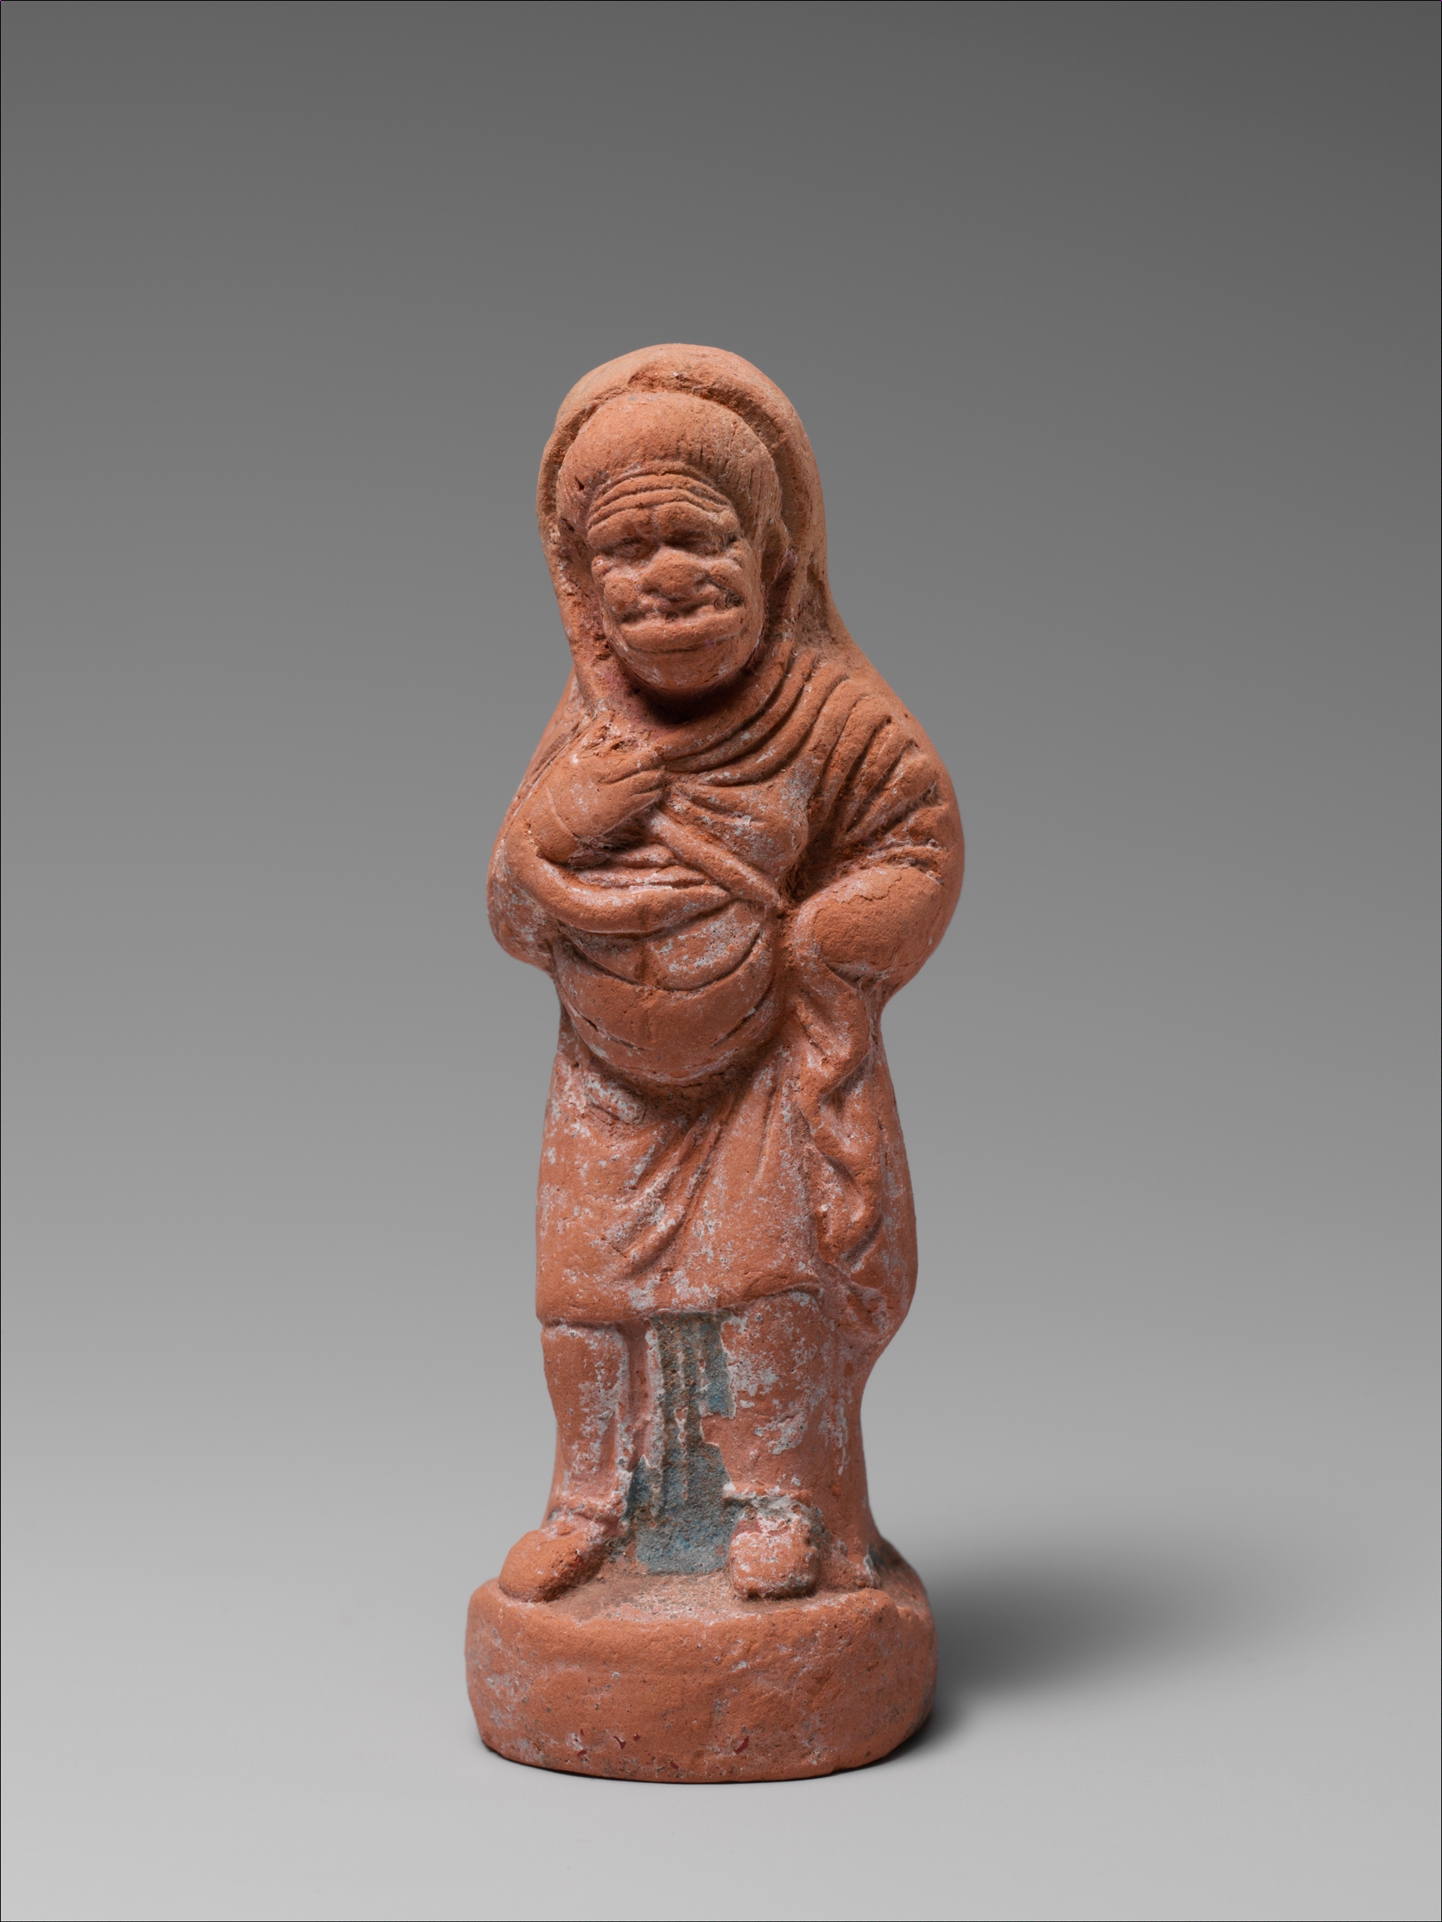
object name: statuette of an actor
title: Terracotta statuette of an actor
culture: greek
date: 434-368 BCE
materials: terracotta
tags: actors